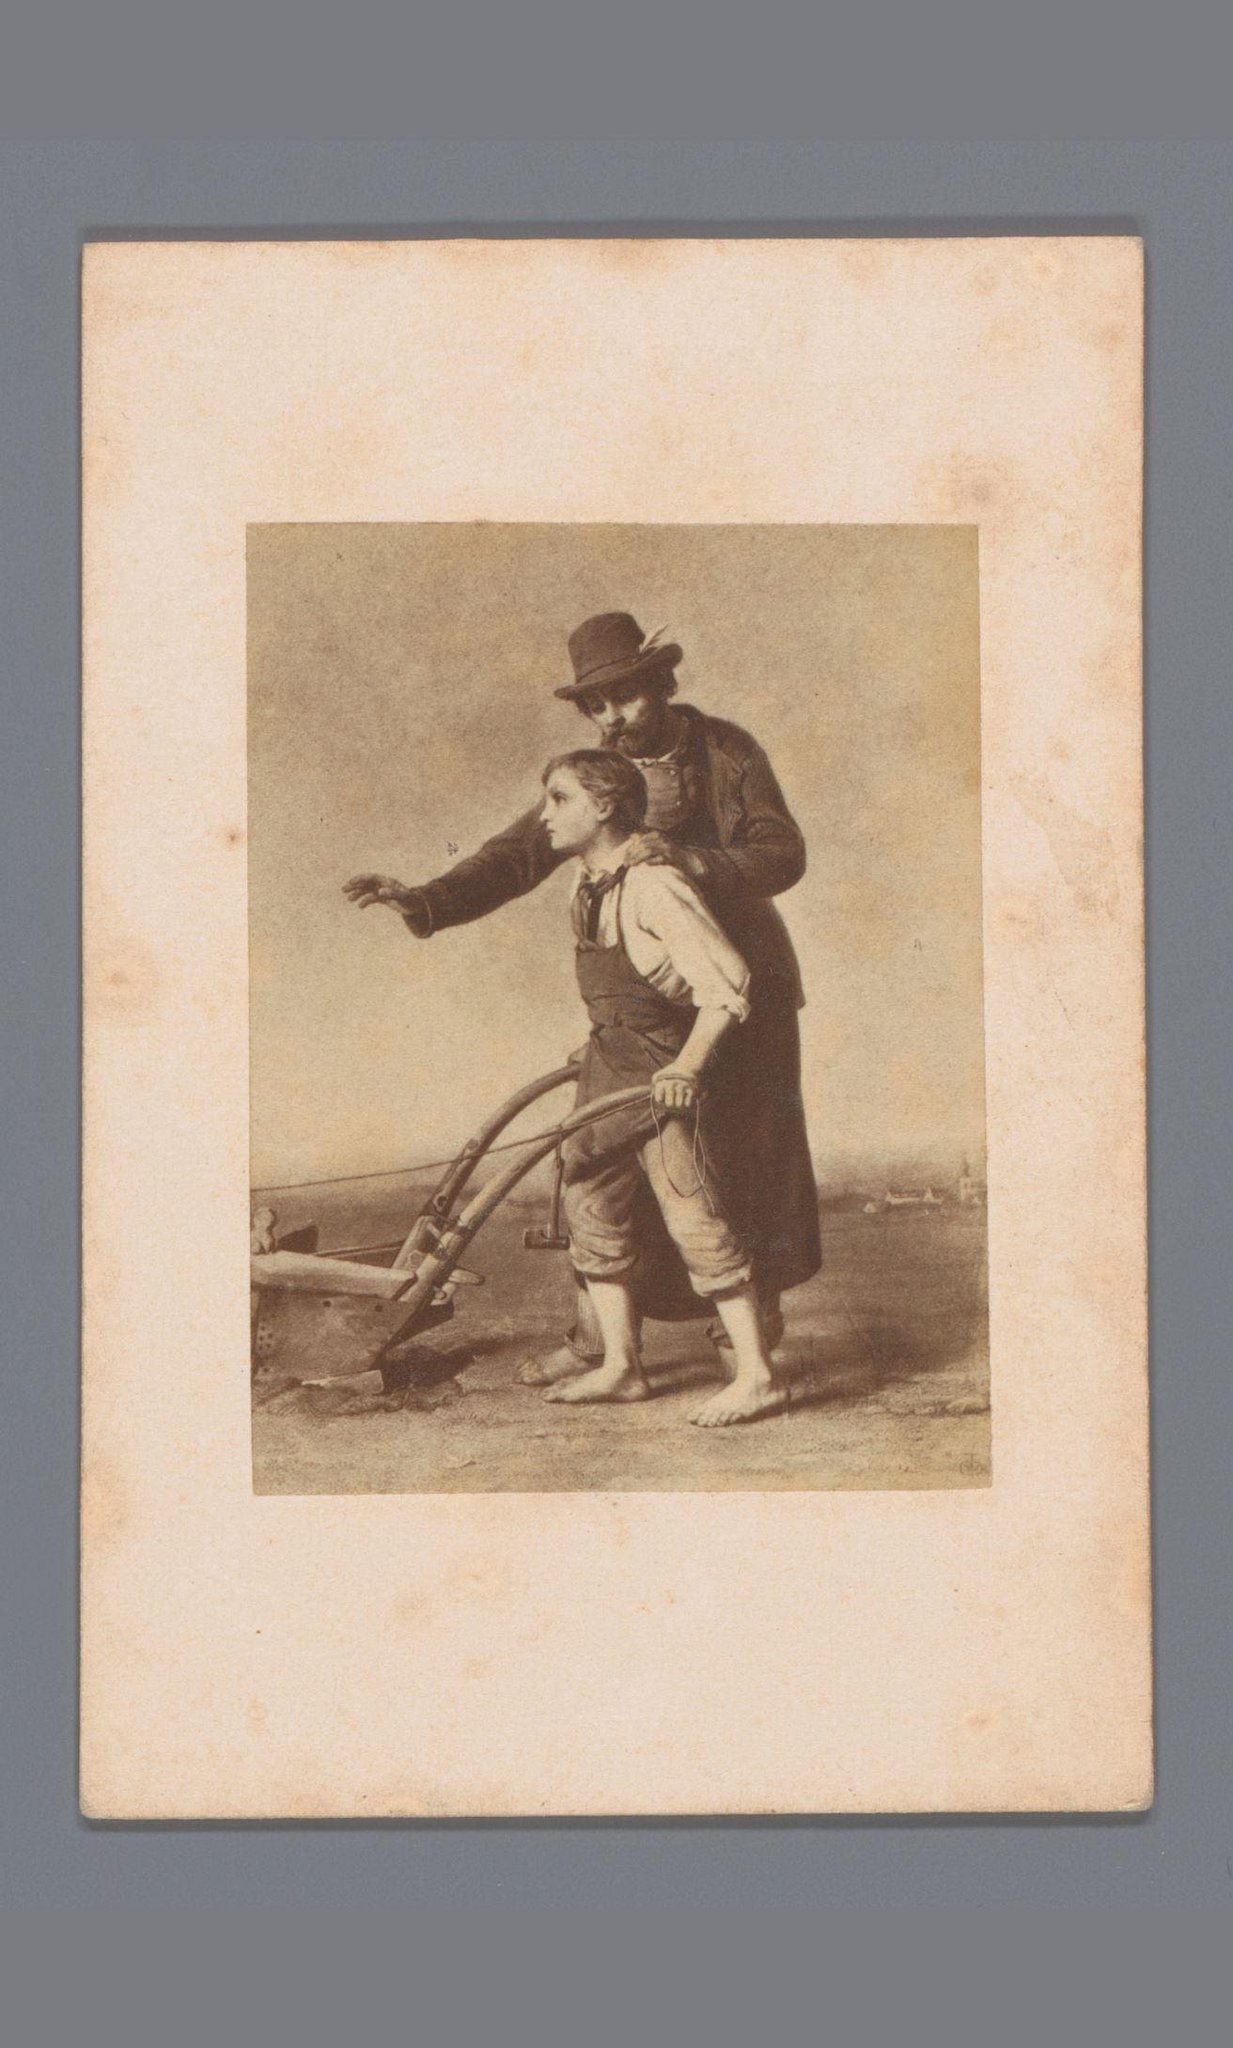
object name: reproduction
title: Fotoreproductie van het schilderij The plough van W.C.T. Dobson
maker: Anonymous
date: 1855-1885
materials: cardboard, paper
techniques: albumen print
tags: father and son(s) (family group), ploughing